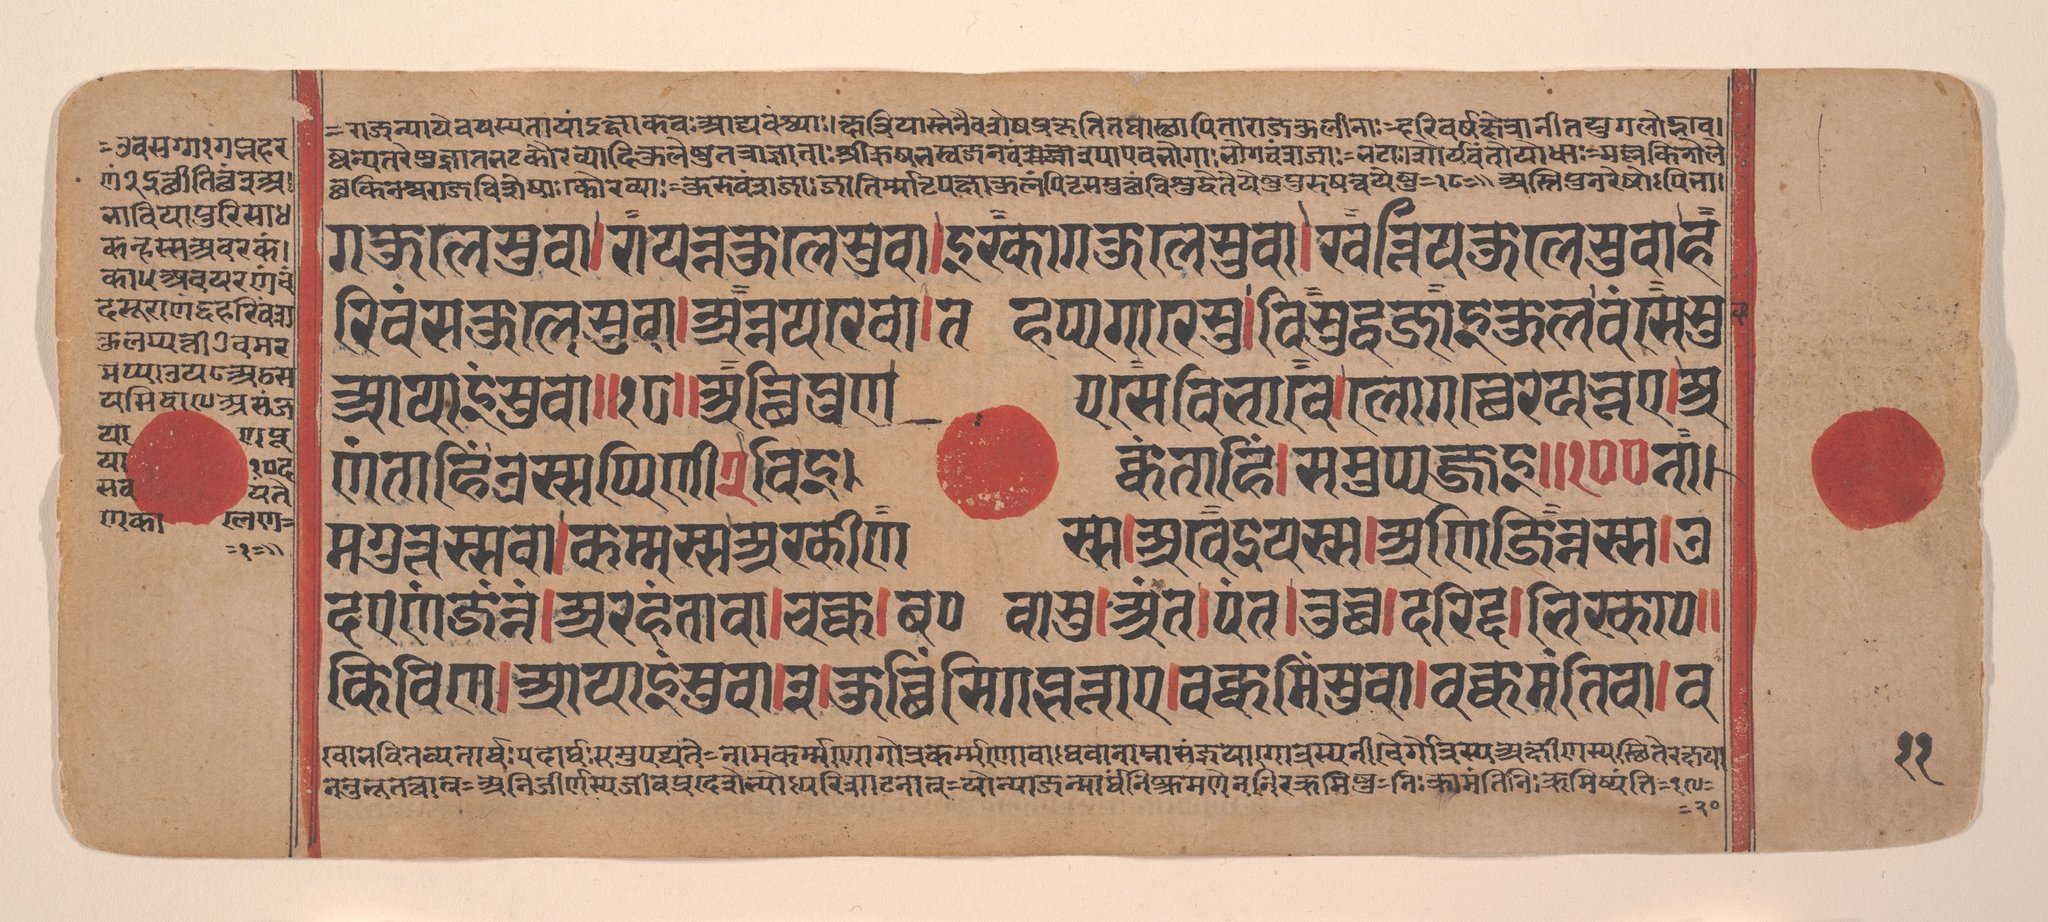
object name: folio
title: Page from a Dispersed Kalpa Sutra (Jain Book of Rituals)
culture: indian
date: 1401-1500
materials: gold, ink, paper, watercolor